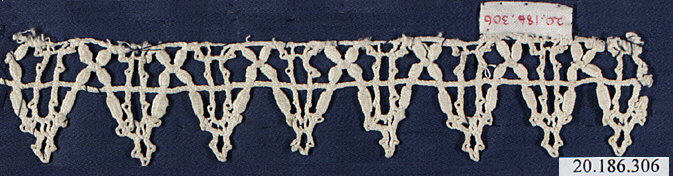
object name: edging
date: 1501-1600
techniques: lace